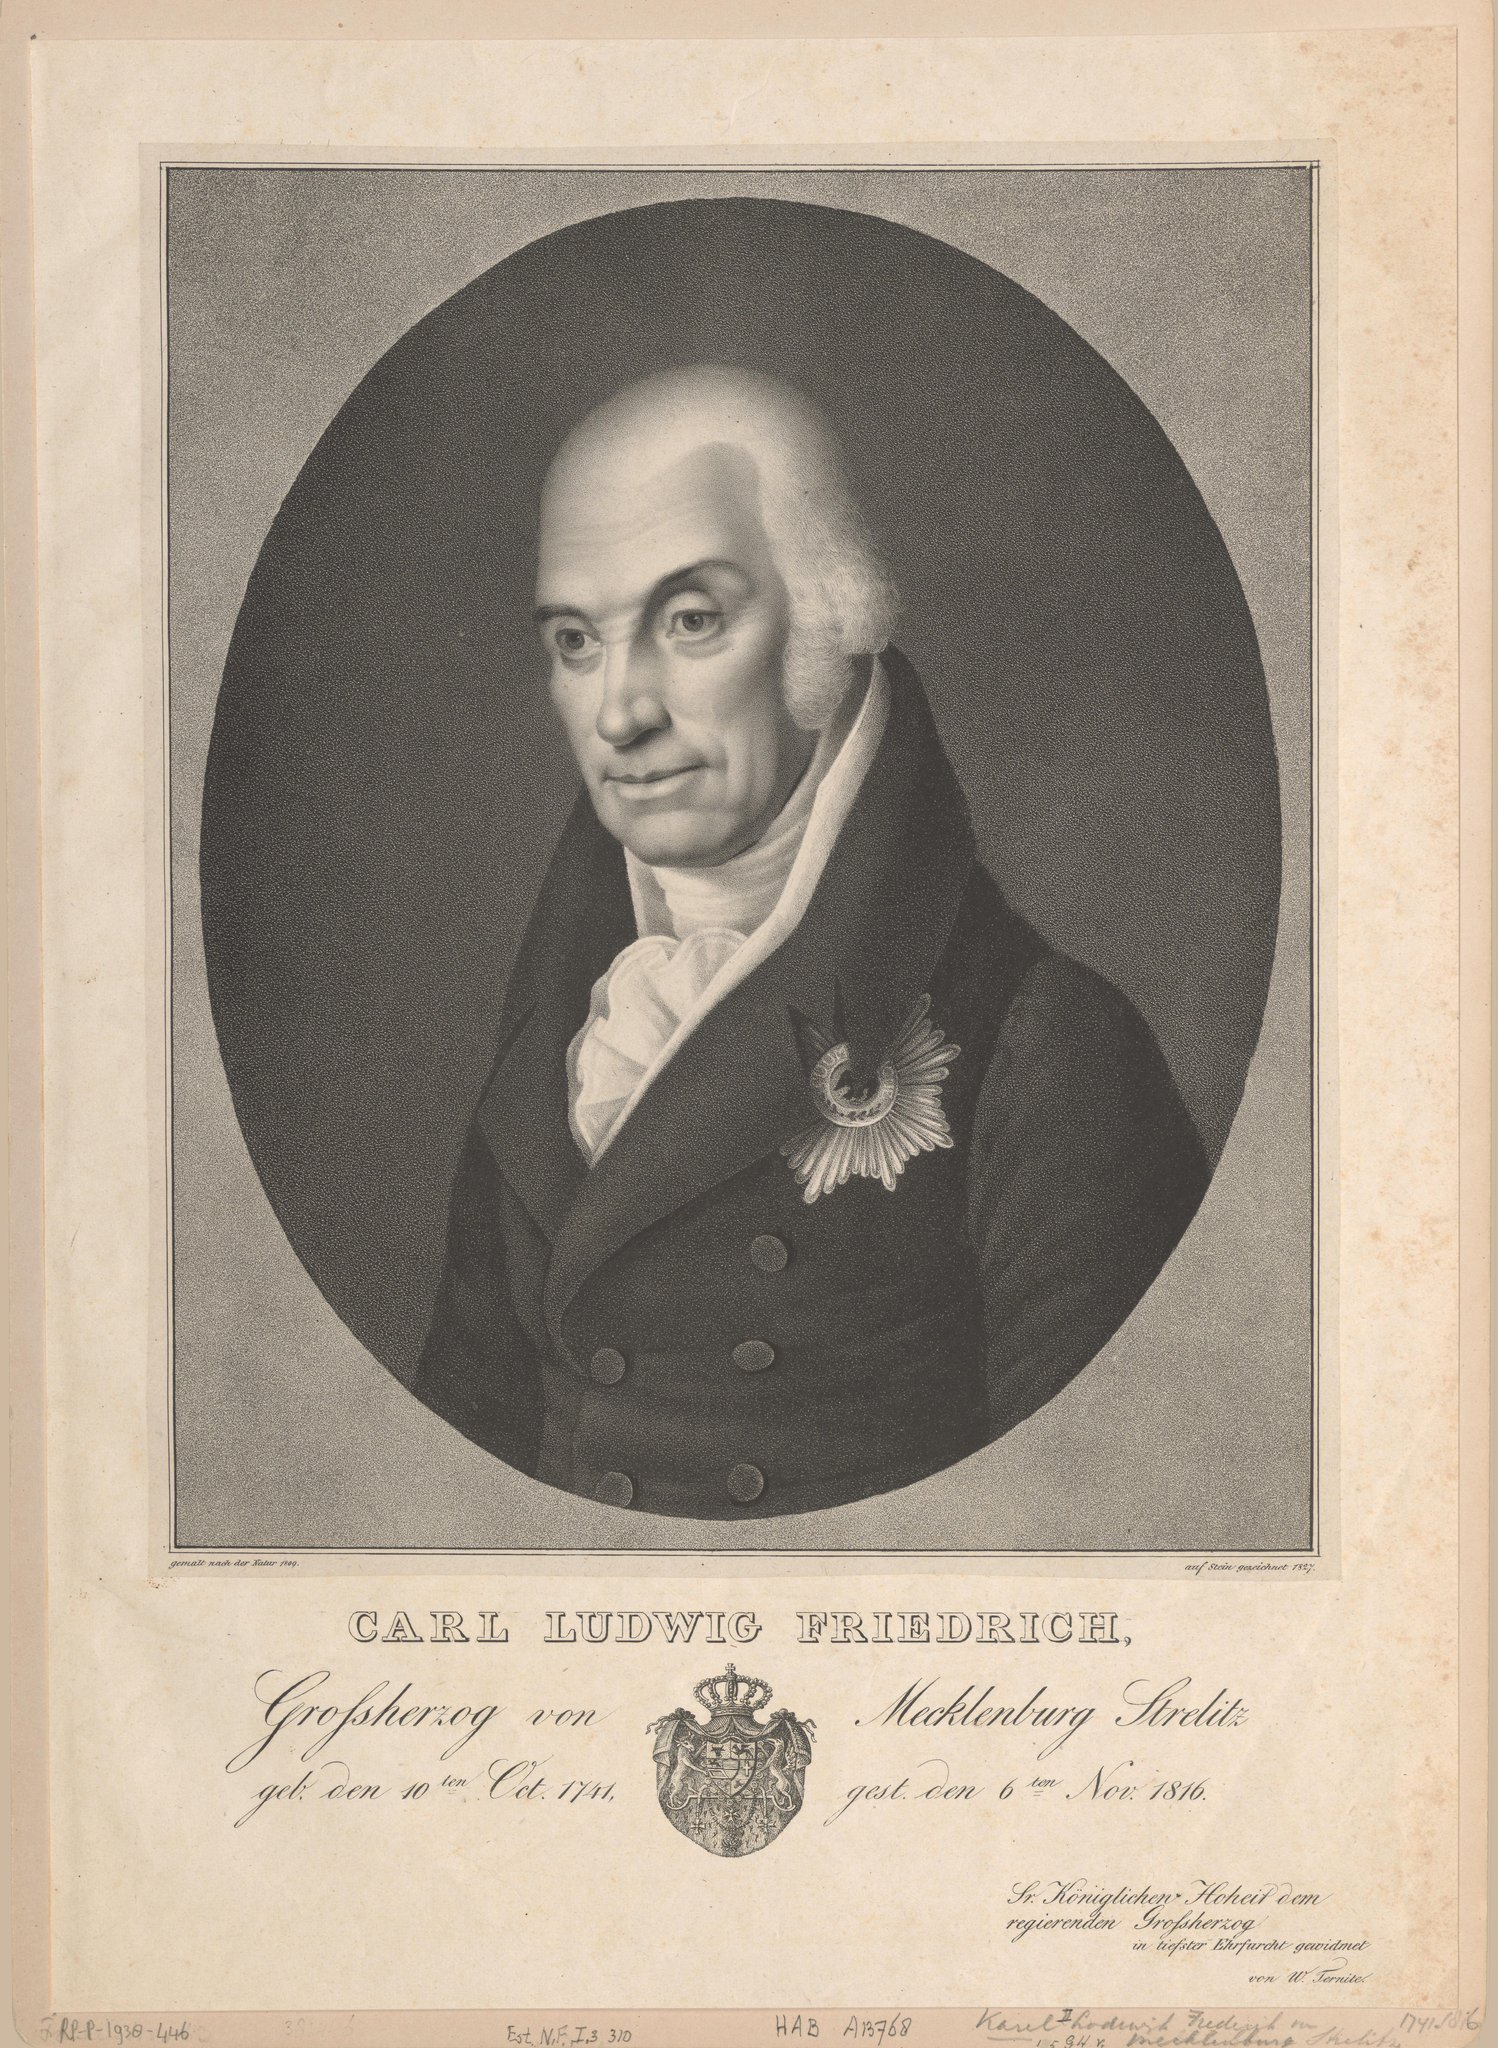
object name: print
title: Portret van Karel II van Mecklenburg-Strelitz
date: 1827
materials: paper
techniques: lithograph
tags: historical persons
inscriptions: collector's mark: Lugt 2228